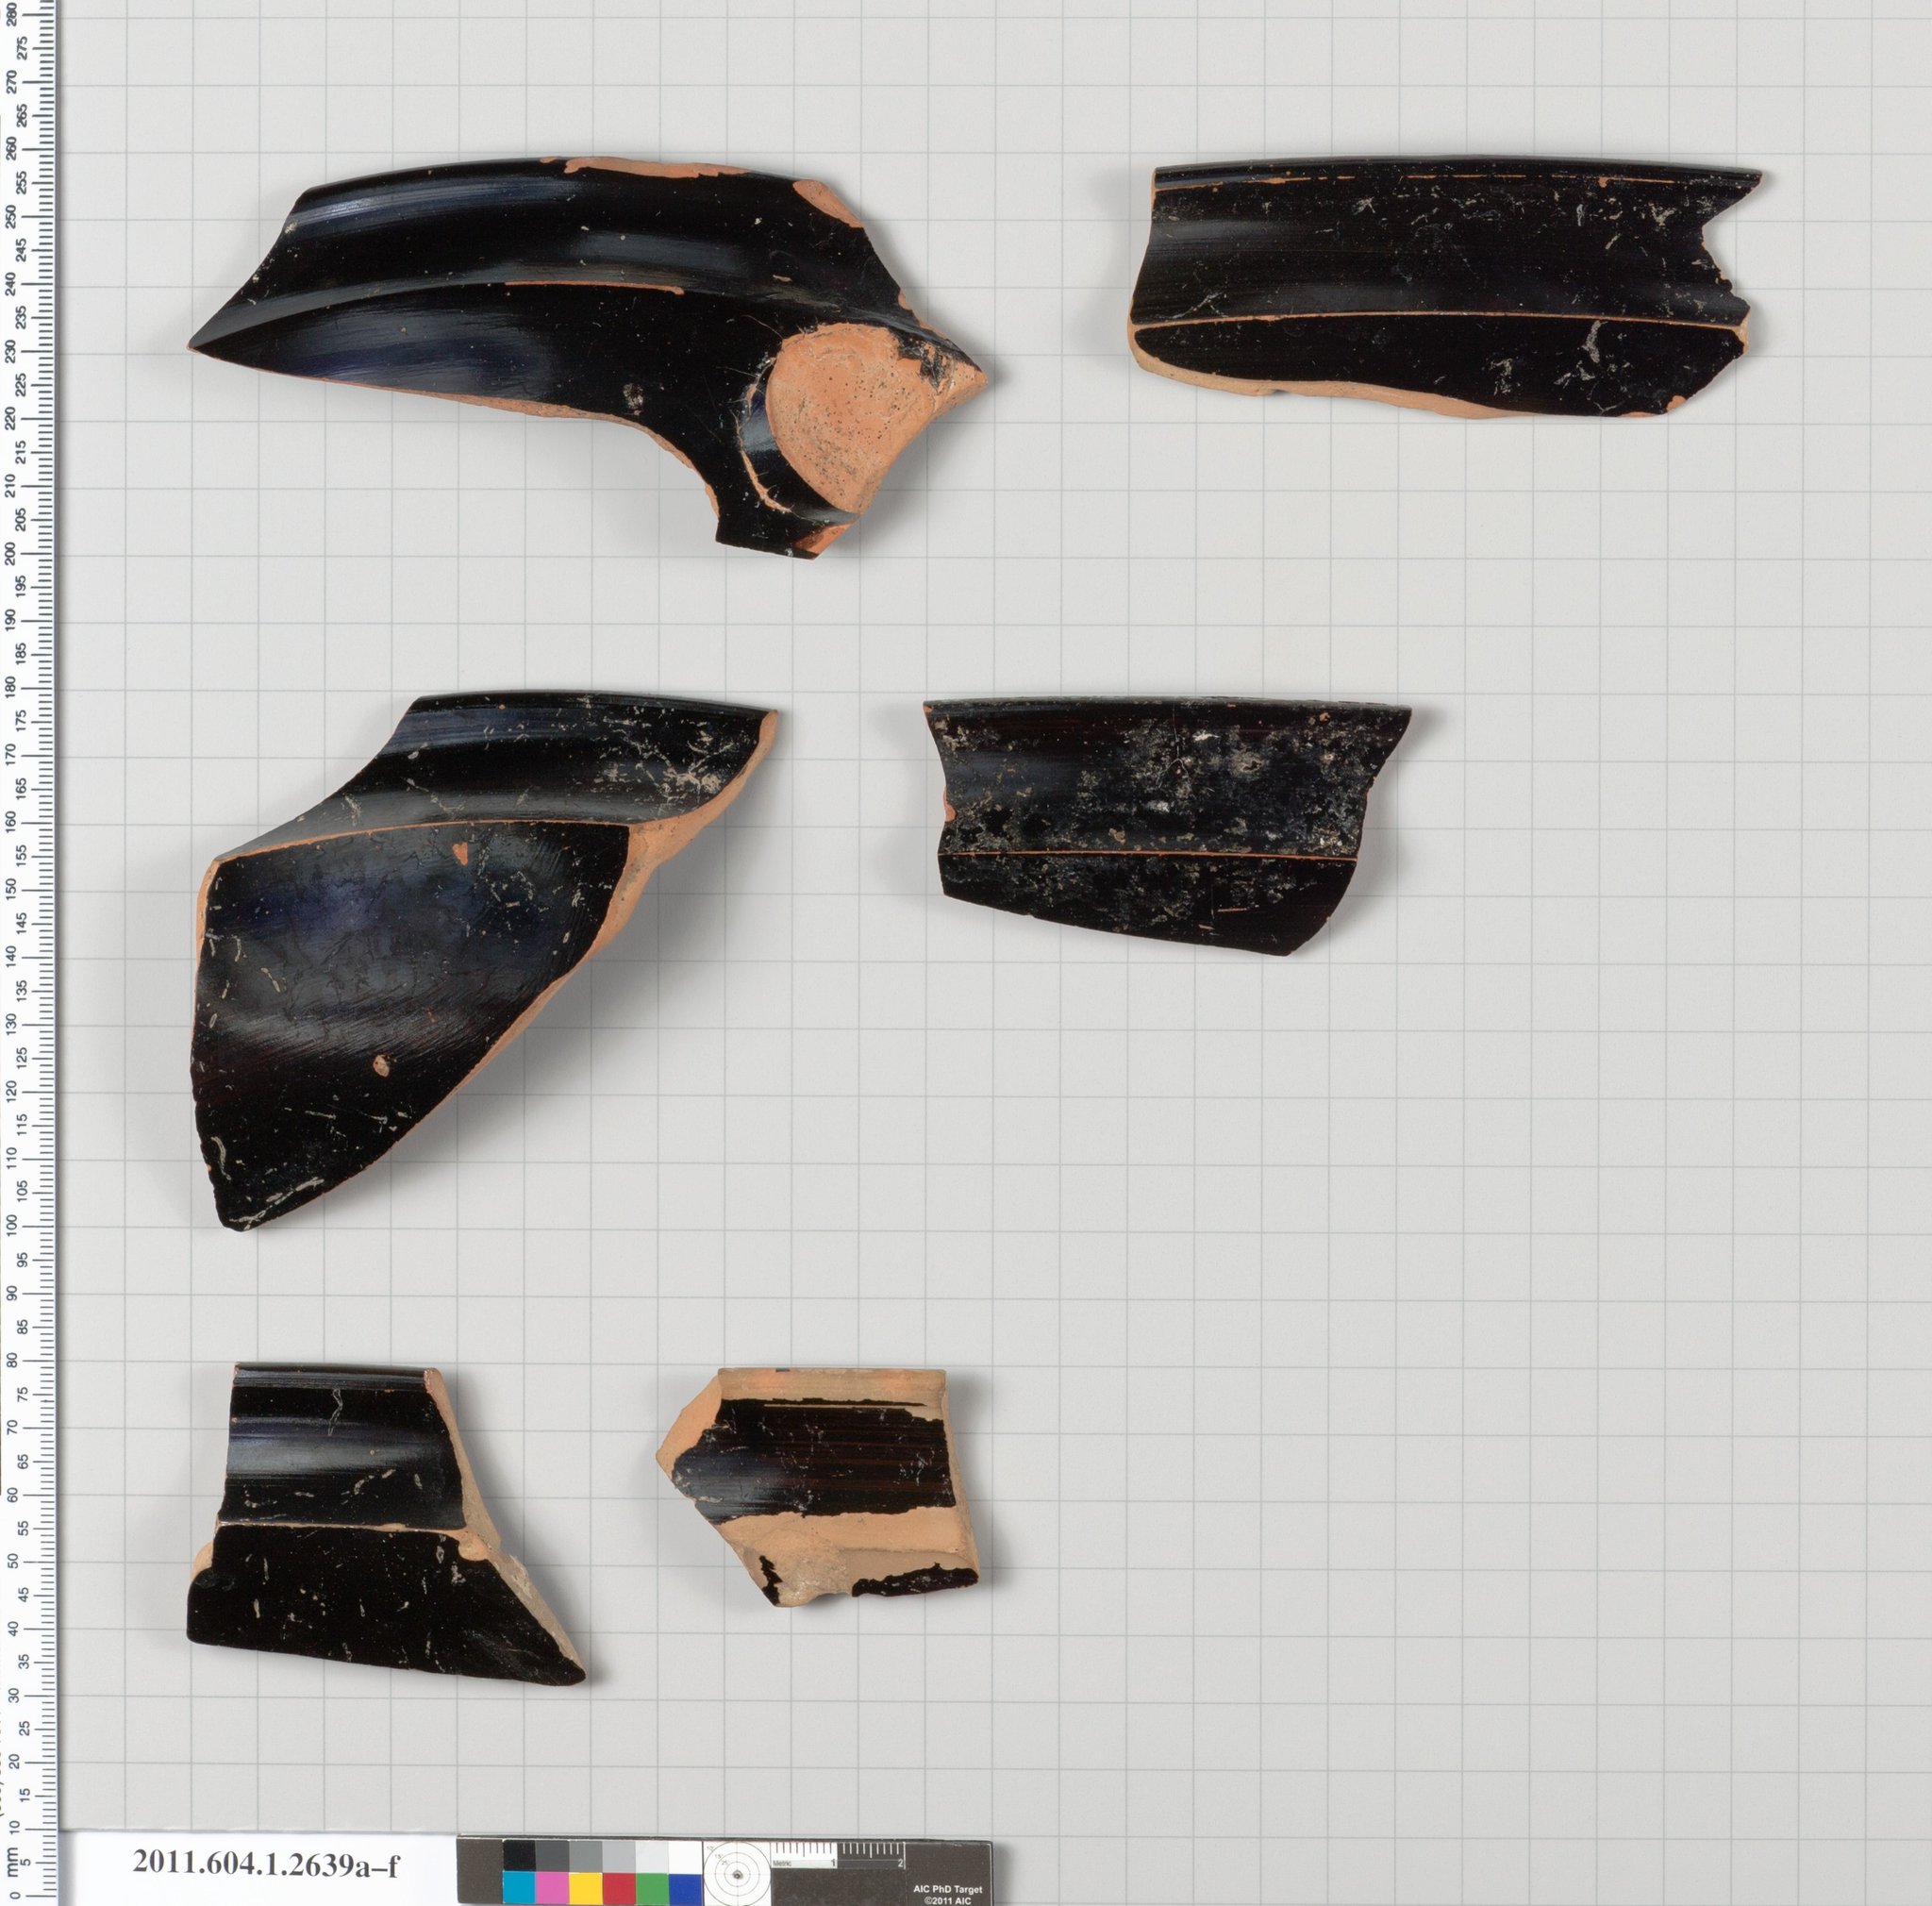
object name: kylix fragment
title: Terracotta rim fragments of kylikes (drinking cups)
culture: greek, attic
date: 520-500 BCE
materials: terracotta